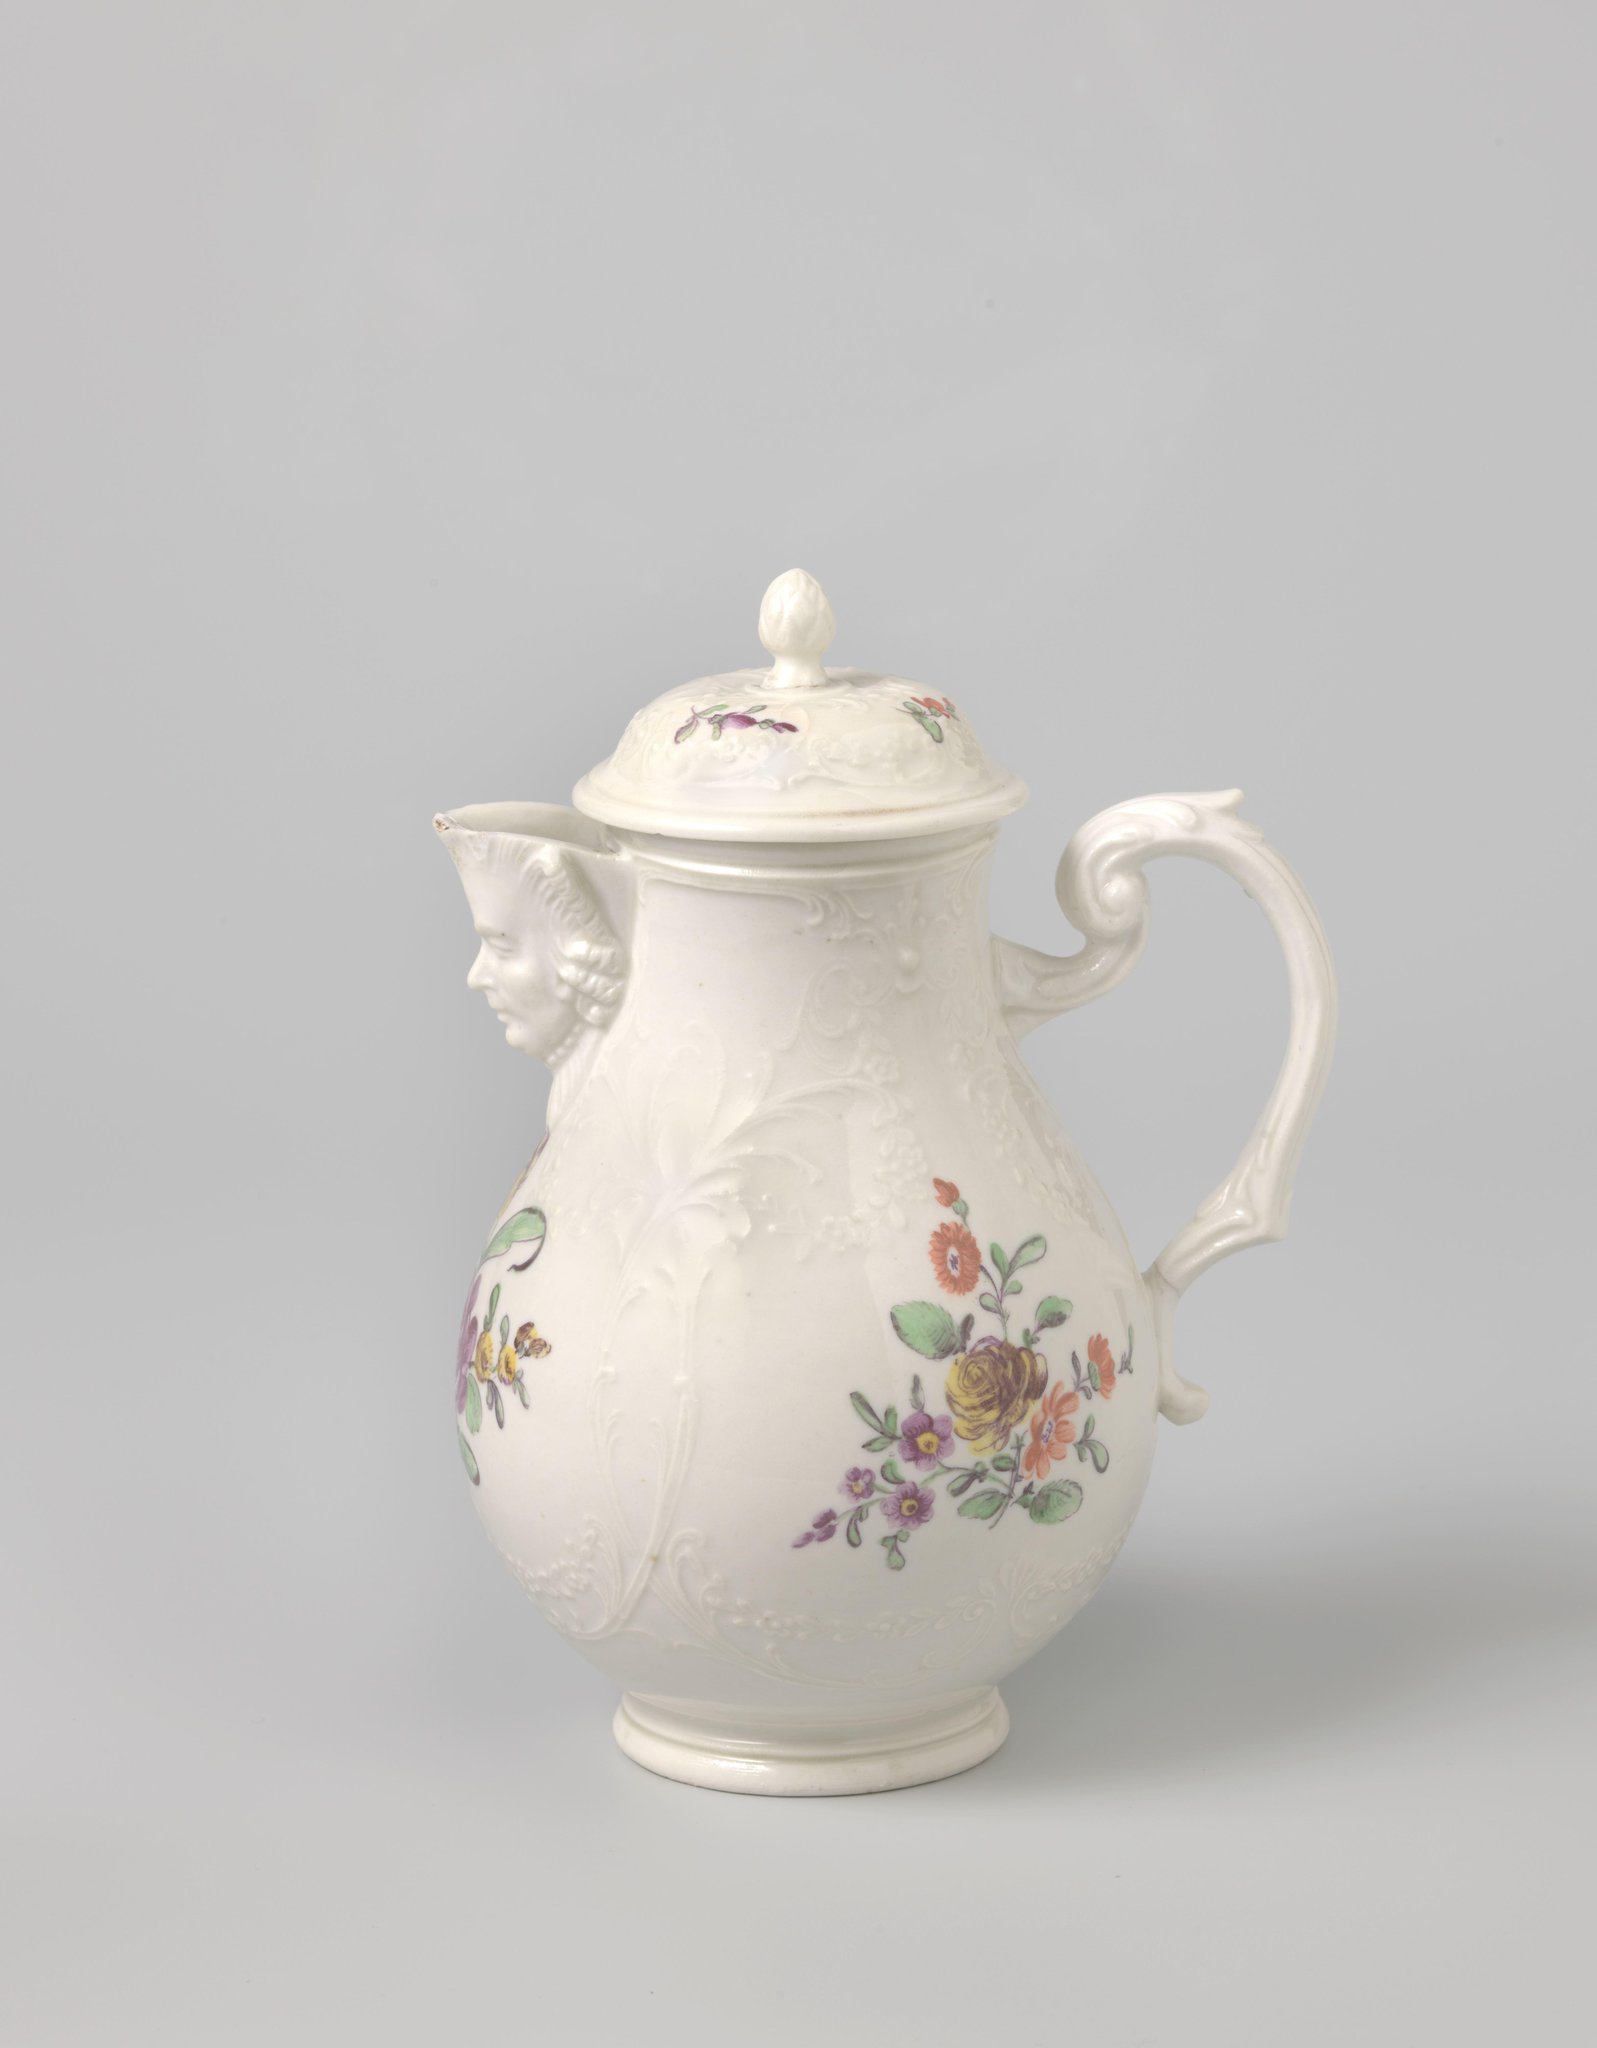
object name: ewer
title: Ewer with bouquets and floral scrolls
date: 1775-1780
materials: glaze, paint, porcelain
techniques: firing, forming, turning, vitrification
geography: würzburg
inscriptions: mark: ‘W/ LM’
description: Kan van porselein met rocaille oor en driehoekige tuit vanuit de nek, beschilderd op het glazuur in rood, groen, geel en zwart. De kan is versierd met vakken van bloemranken in licht reliëf met daarin geschilderde boeketten. De tuit is gemodelleerd in de vorm van een hoofd. Gemerkt op de onderzijde met de W en LM.